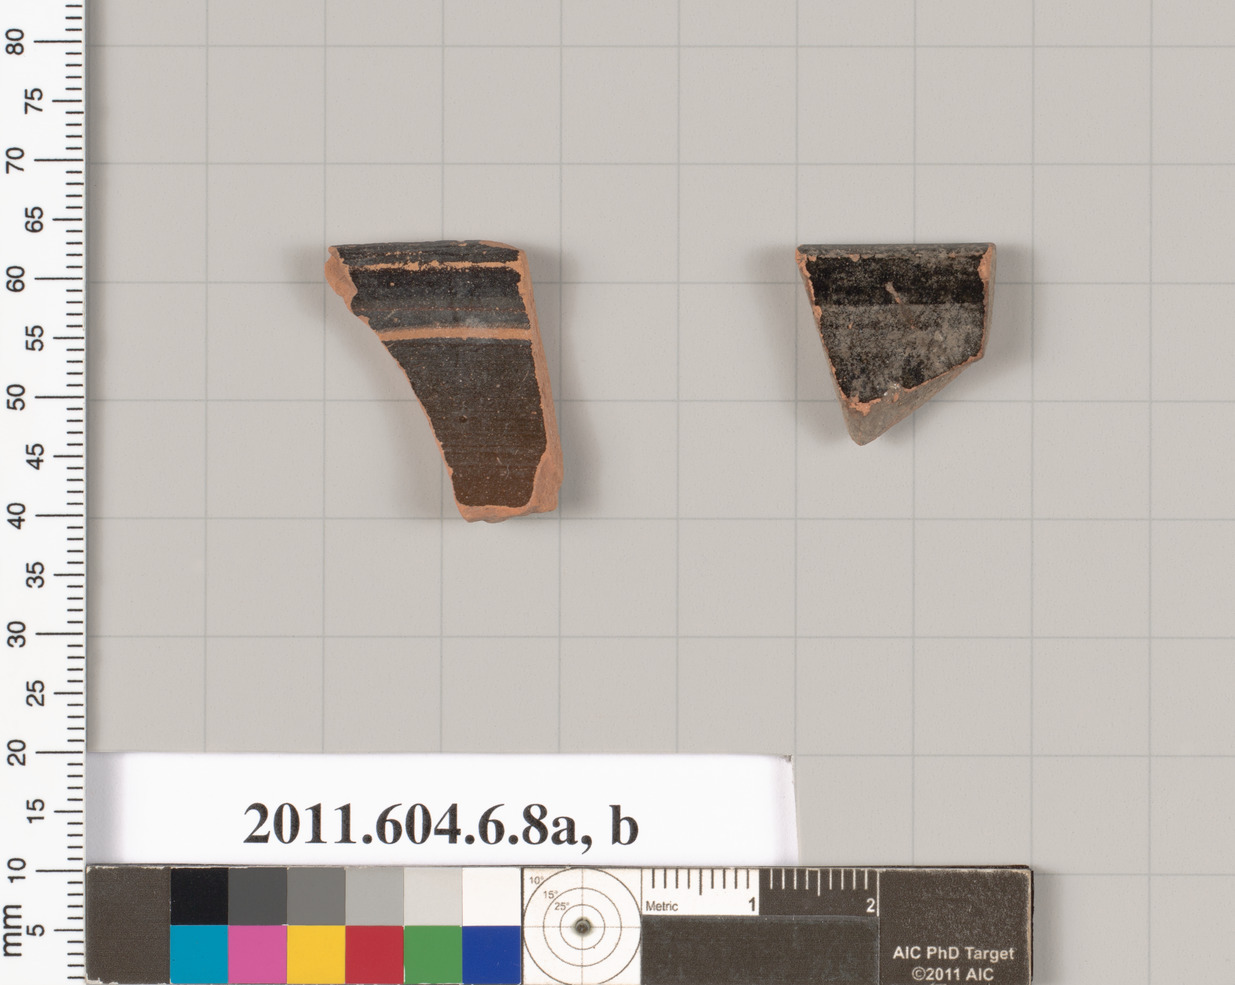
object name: undetermined open shape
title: Terracotta rim fragments of open shapes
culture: greek, attic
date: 600-401 BCE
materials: terracotta